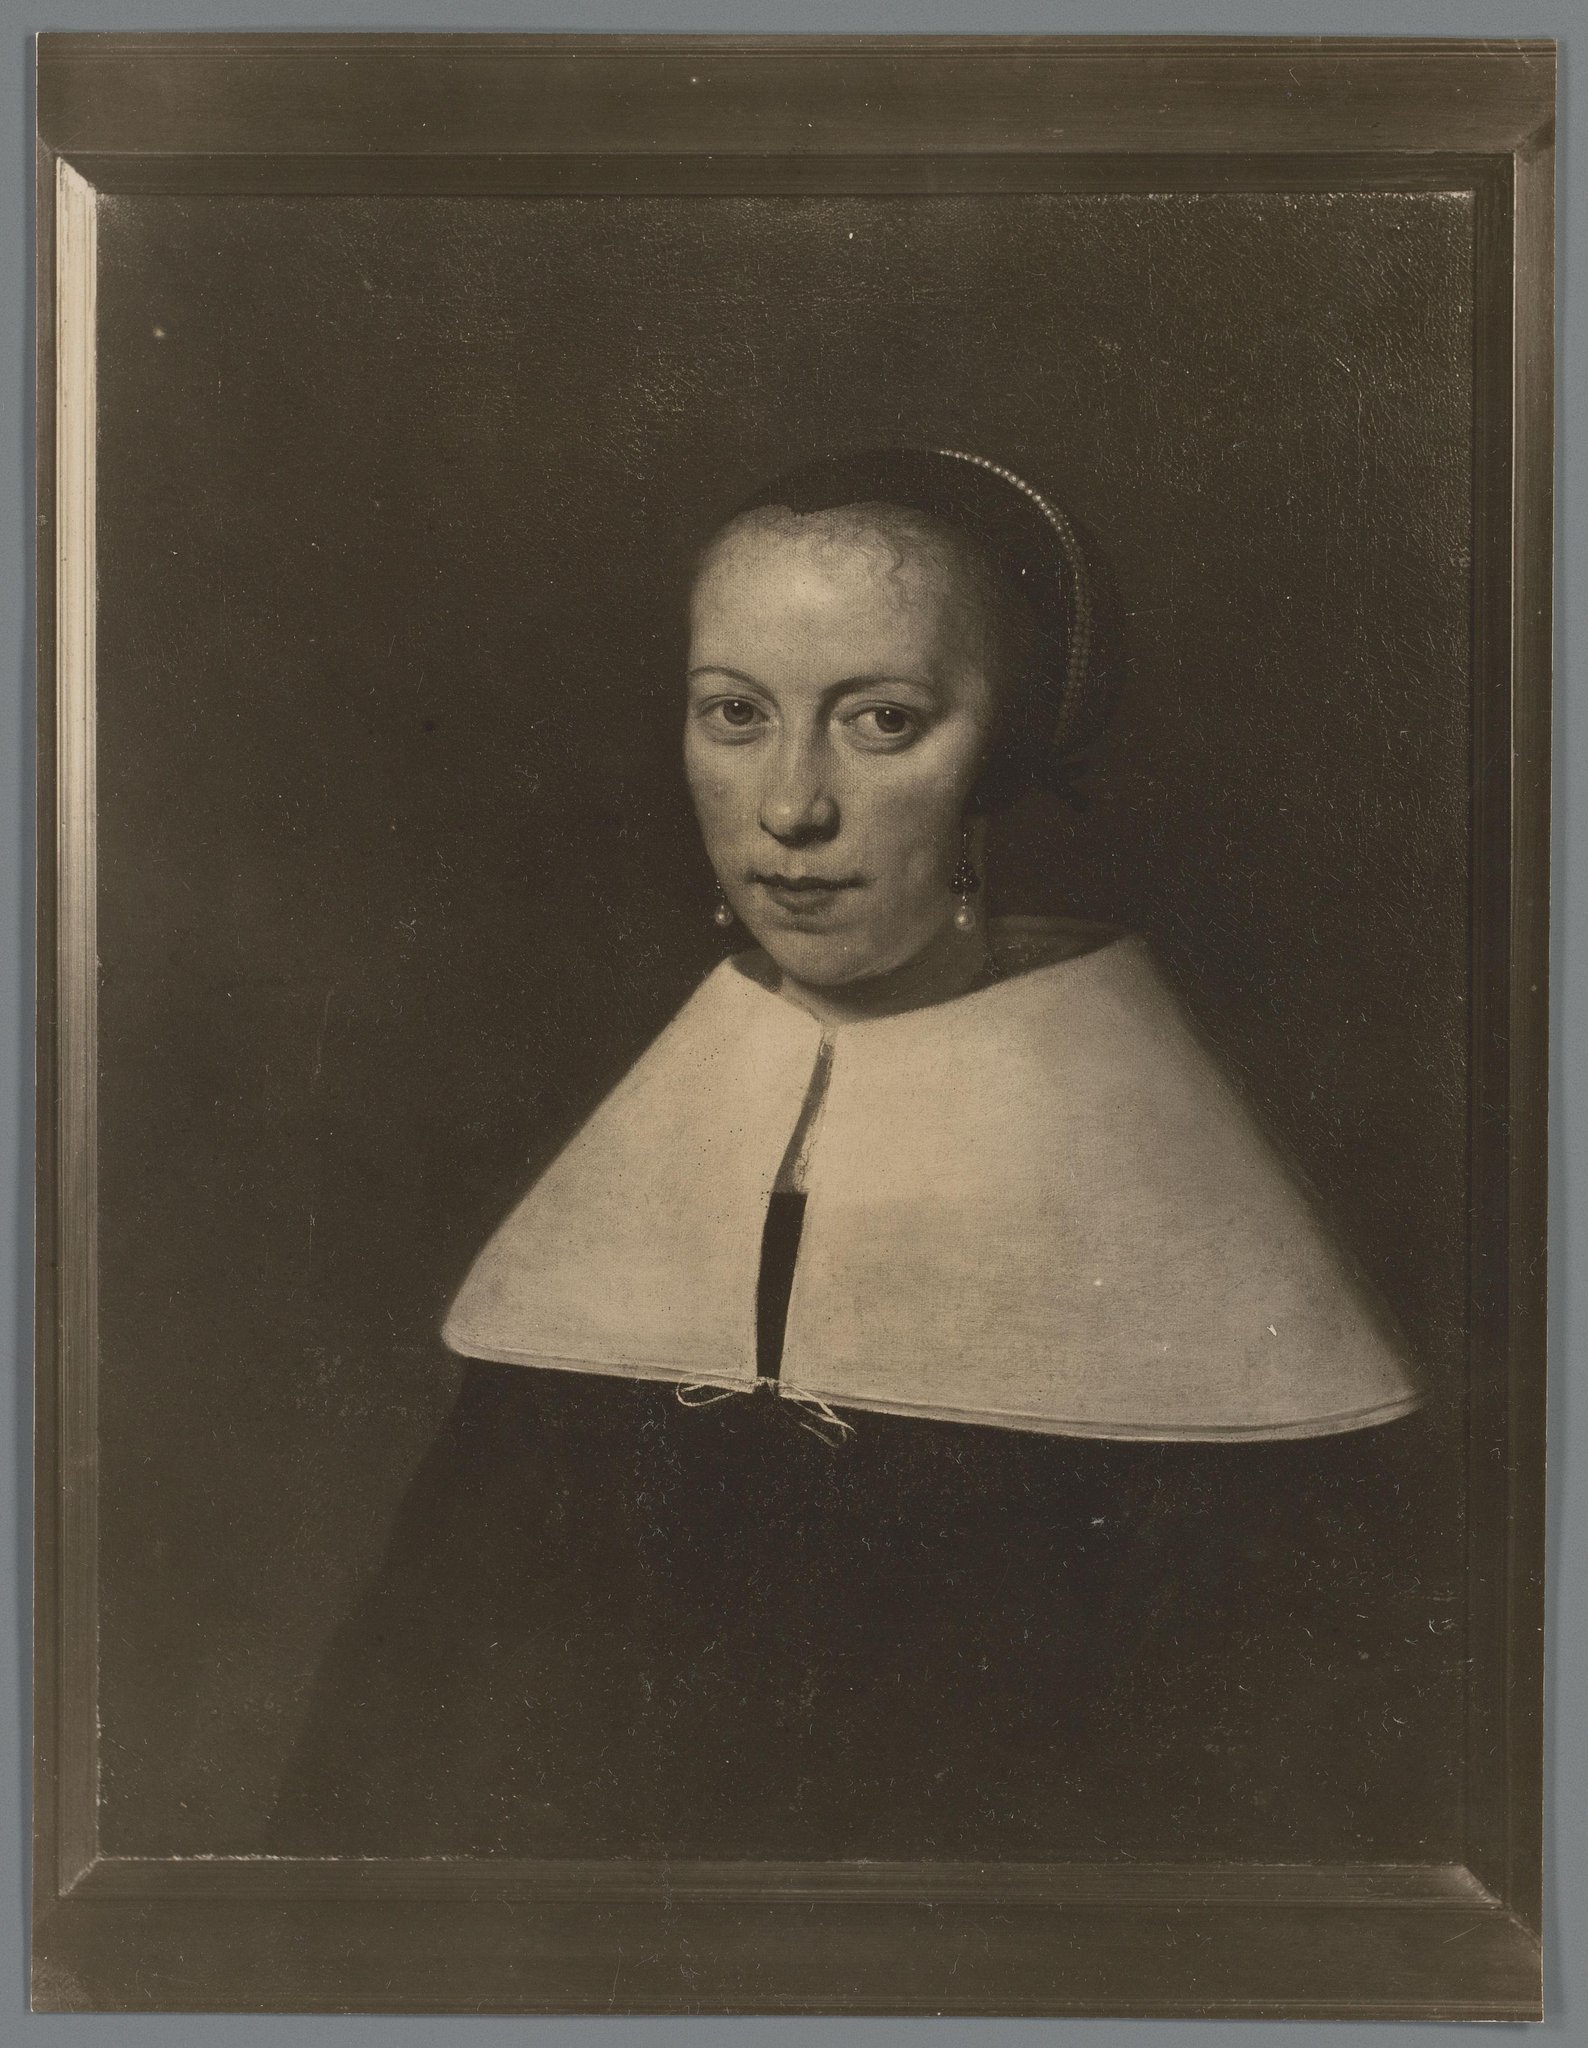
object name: reproduction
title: Fotoreproductie van een geschilderd portret van een vrouw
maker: Anonymous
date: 1910-1990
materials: paper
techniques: gelatin silver print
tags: adult woman, historical persons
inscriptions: number: ‘No 499’